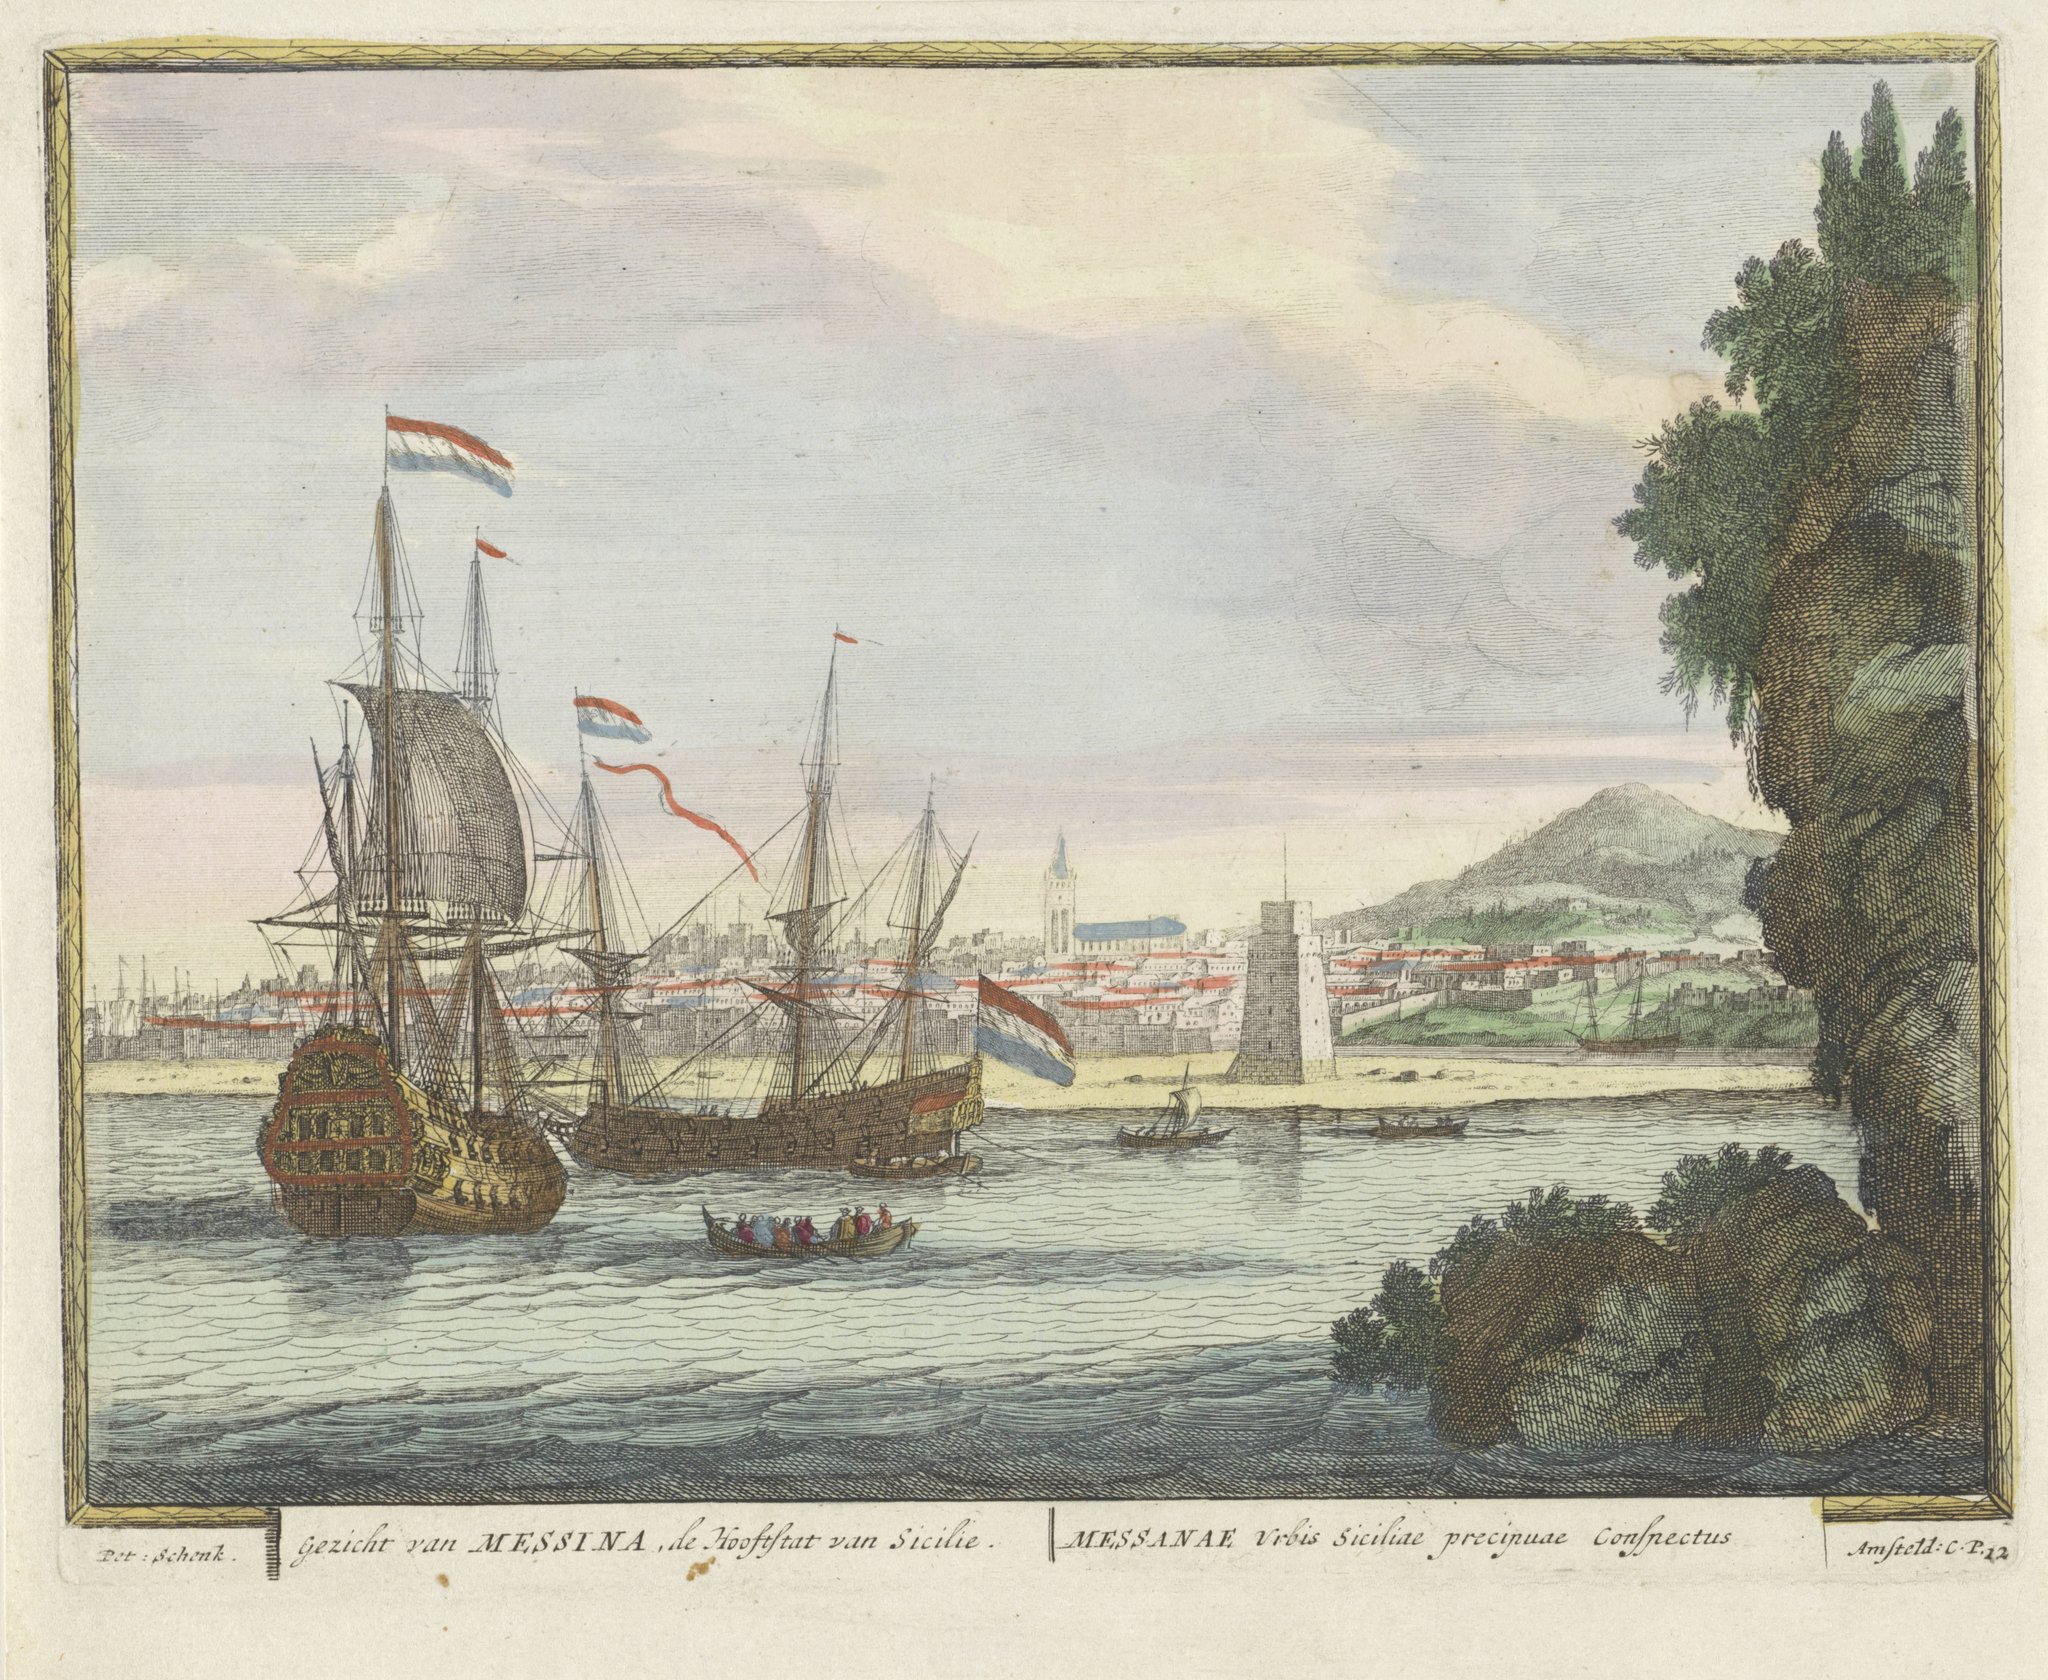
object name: print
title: Profielen van steden over heel de wereld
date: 1675-1711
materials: paper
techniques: brush, engraving, etching, hand coloring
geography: amsterdam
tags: sailing-ship, sailing-boat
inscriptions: collector's mark: Lugt 2228